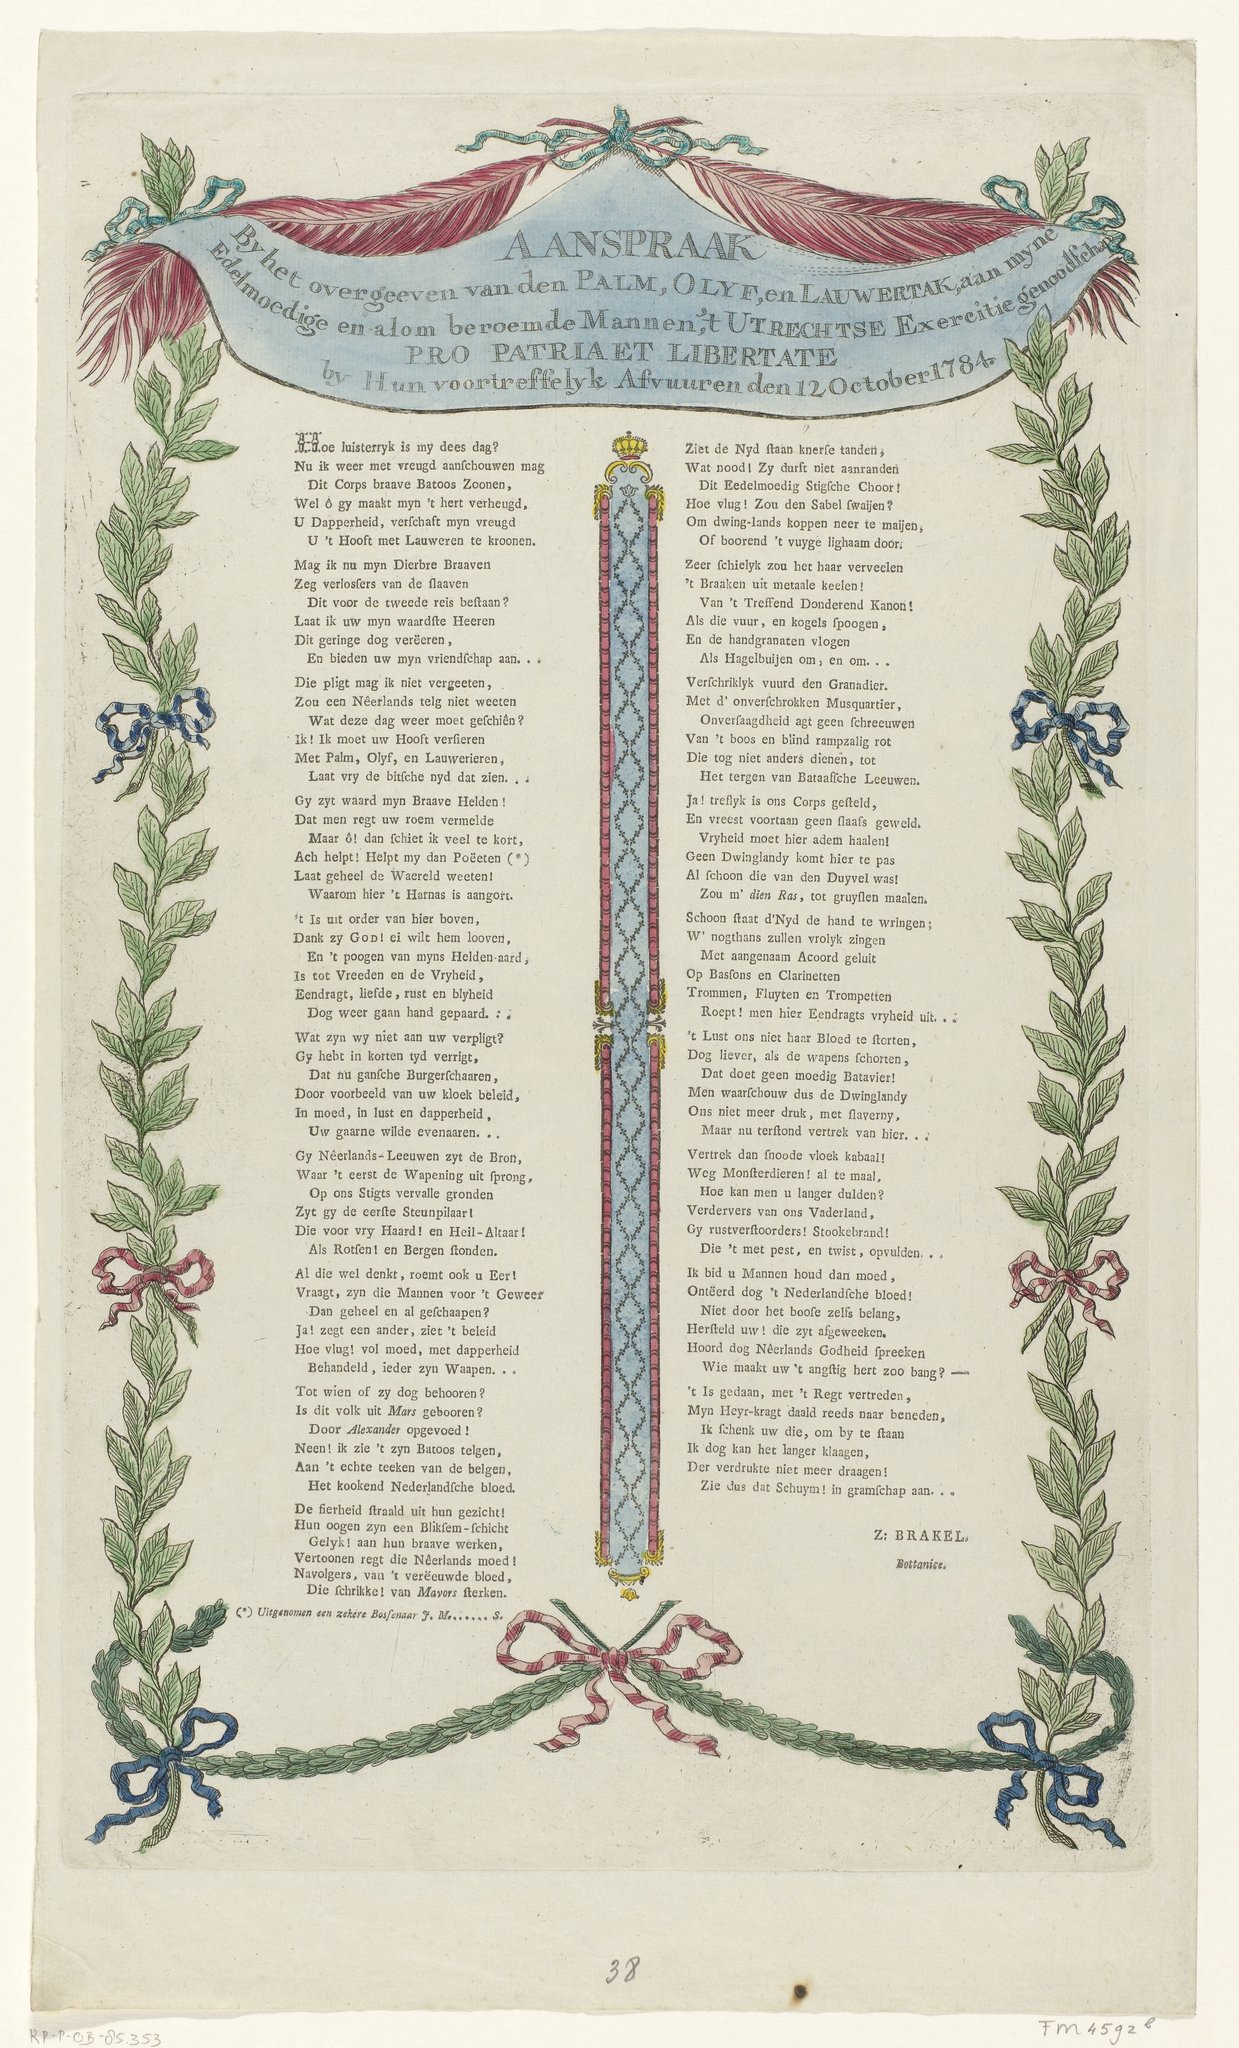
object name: print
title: Aanspraak By het overgeeven van den Palm, Olyf, en Lauwertak, aan myne Edelmoedige en alom beroemde Mannen, 't Utrechtse Exercitie genoodschap Pro Patria et Libertate by Hun voortreffelyk Afvuuren den 12 October 1784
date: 1784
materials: paper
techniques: engraving, etching, hand coloring, letterpress printing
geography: northern netherlands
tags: utrecht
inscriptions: collector's mark: Lugt 2228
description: Vers ter gelegenheid van een schietoefening van het Utrechts Exercitiegeootschap Pro Patria et Libertate, 12 oktober 1784. Vers in twee kolommen binnen een kader van lauwertakken, palmtakken en olijftakken die met linten verbonden zijn.